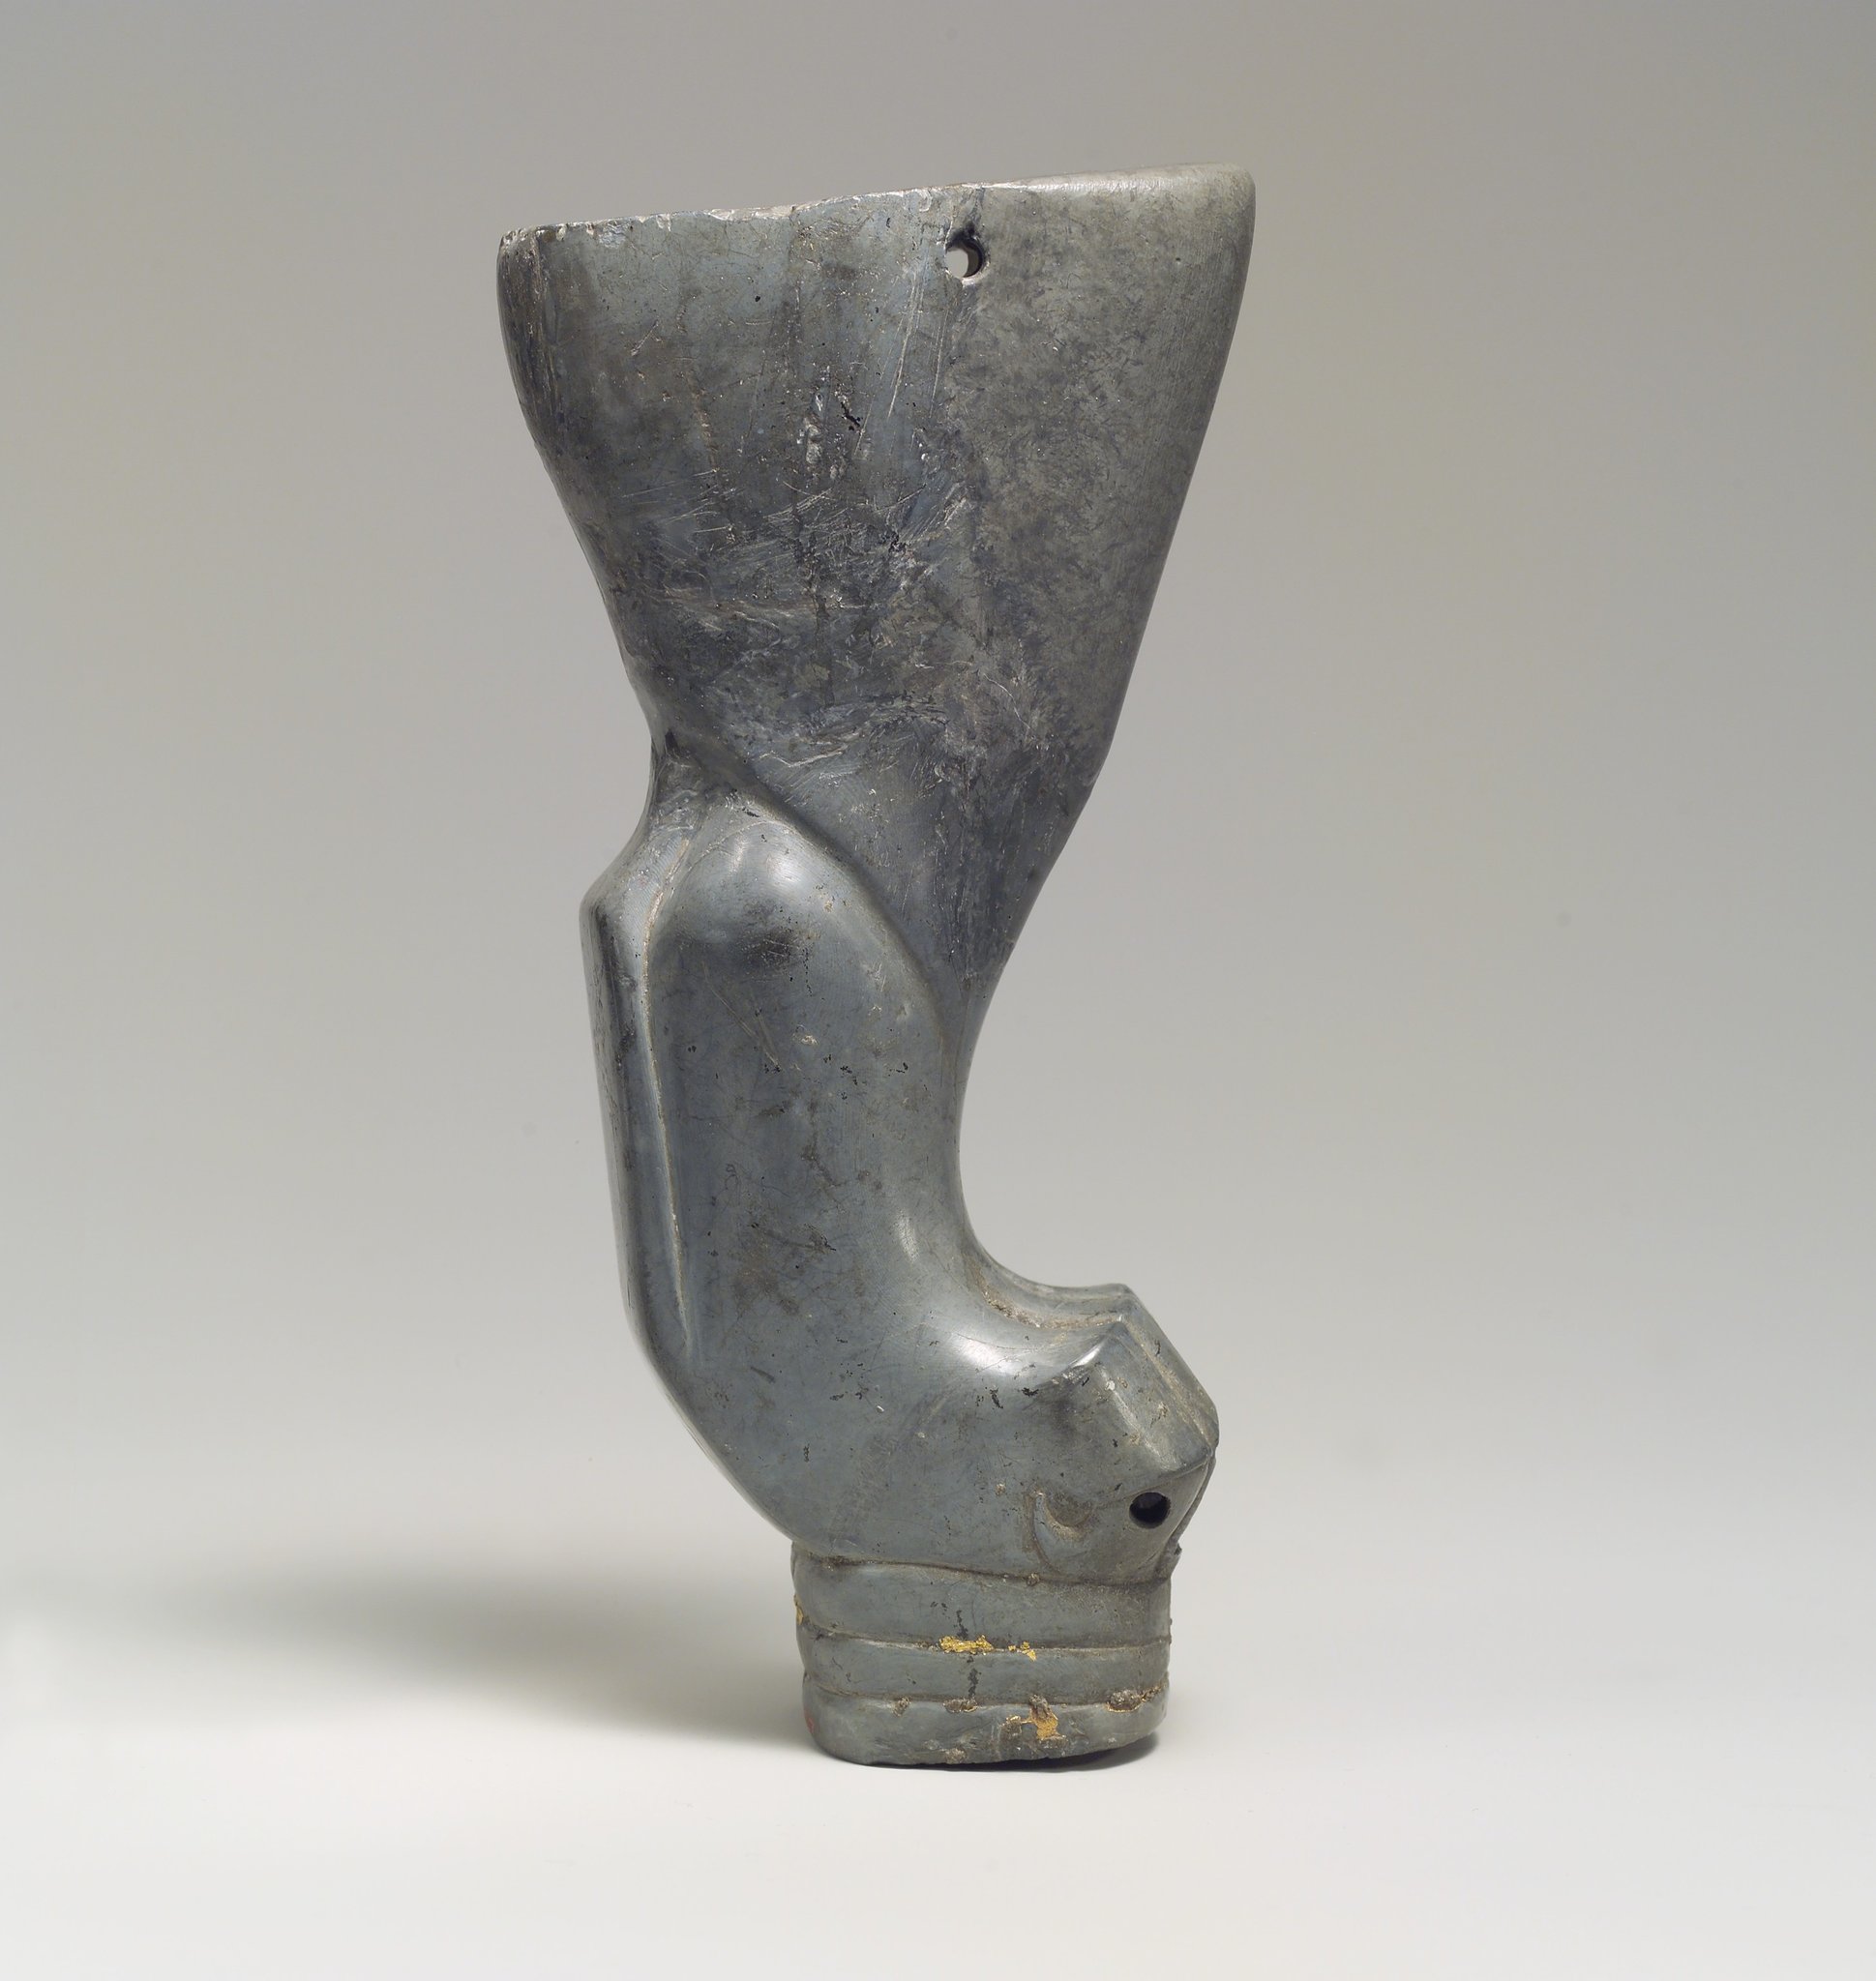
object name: furniture support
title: Furniture support: lion's leg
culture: assyrian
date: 1800-1701 BCE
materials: ivory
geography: anatolia